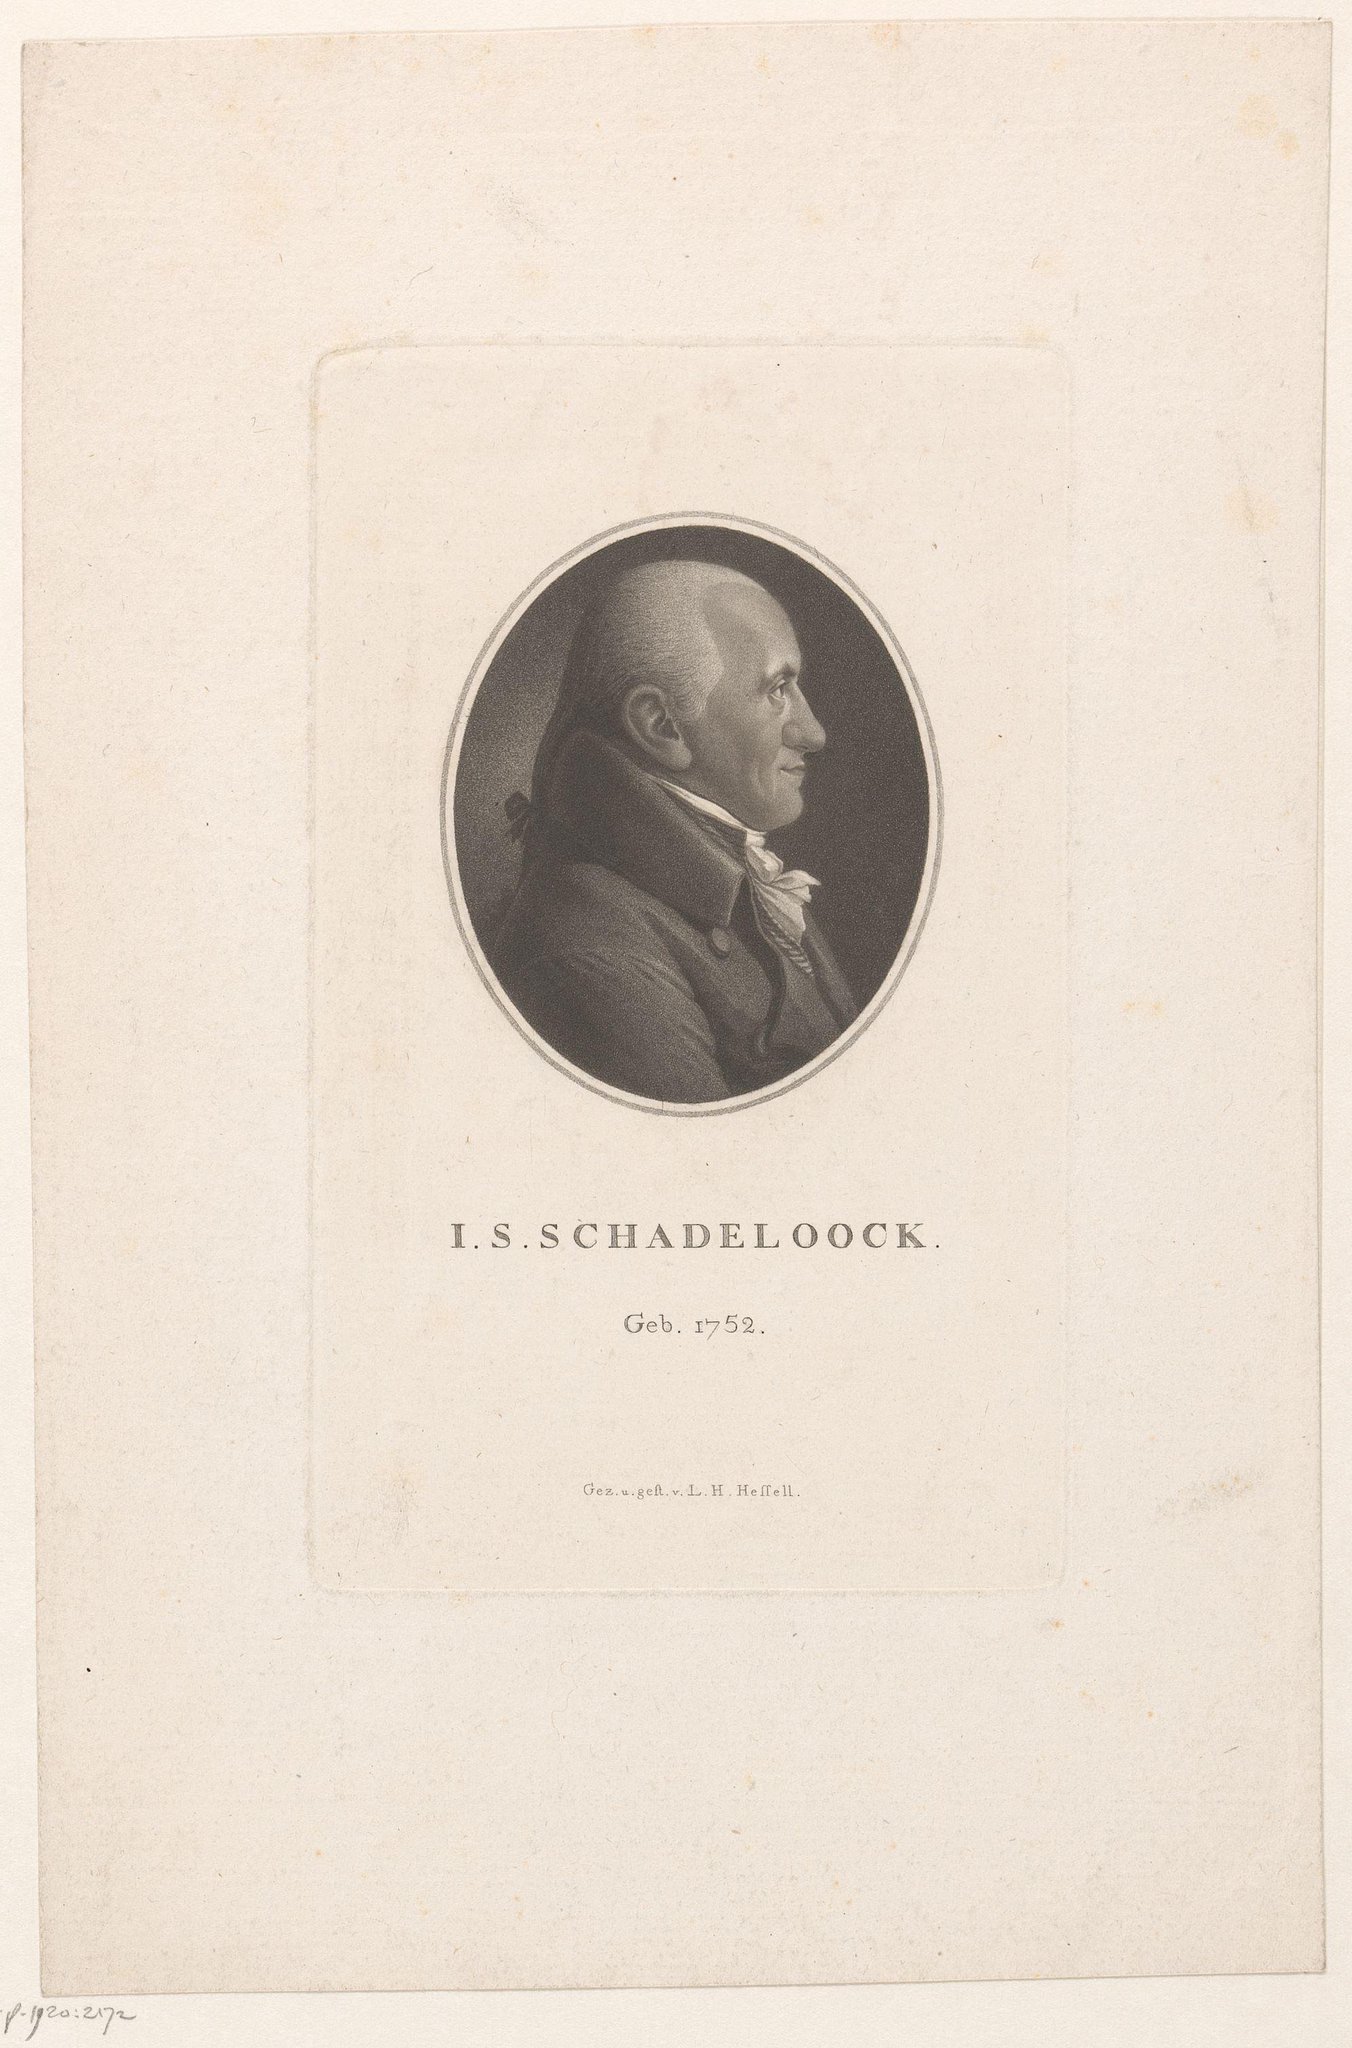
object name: print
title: Portret van Johann Sigmund Schadeloock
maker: leonhard heinrich hessell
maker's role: musical instrument maker, painter, print maker, publisher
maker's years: 1757-1830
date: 1767-1850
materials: paper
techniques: aquatint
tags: historical persons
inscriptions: collector's mark: Lugt 2228